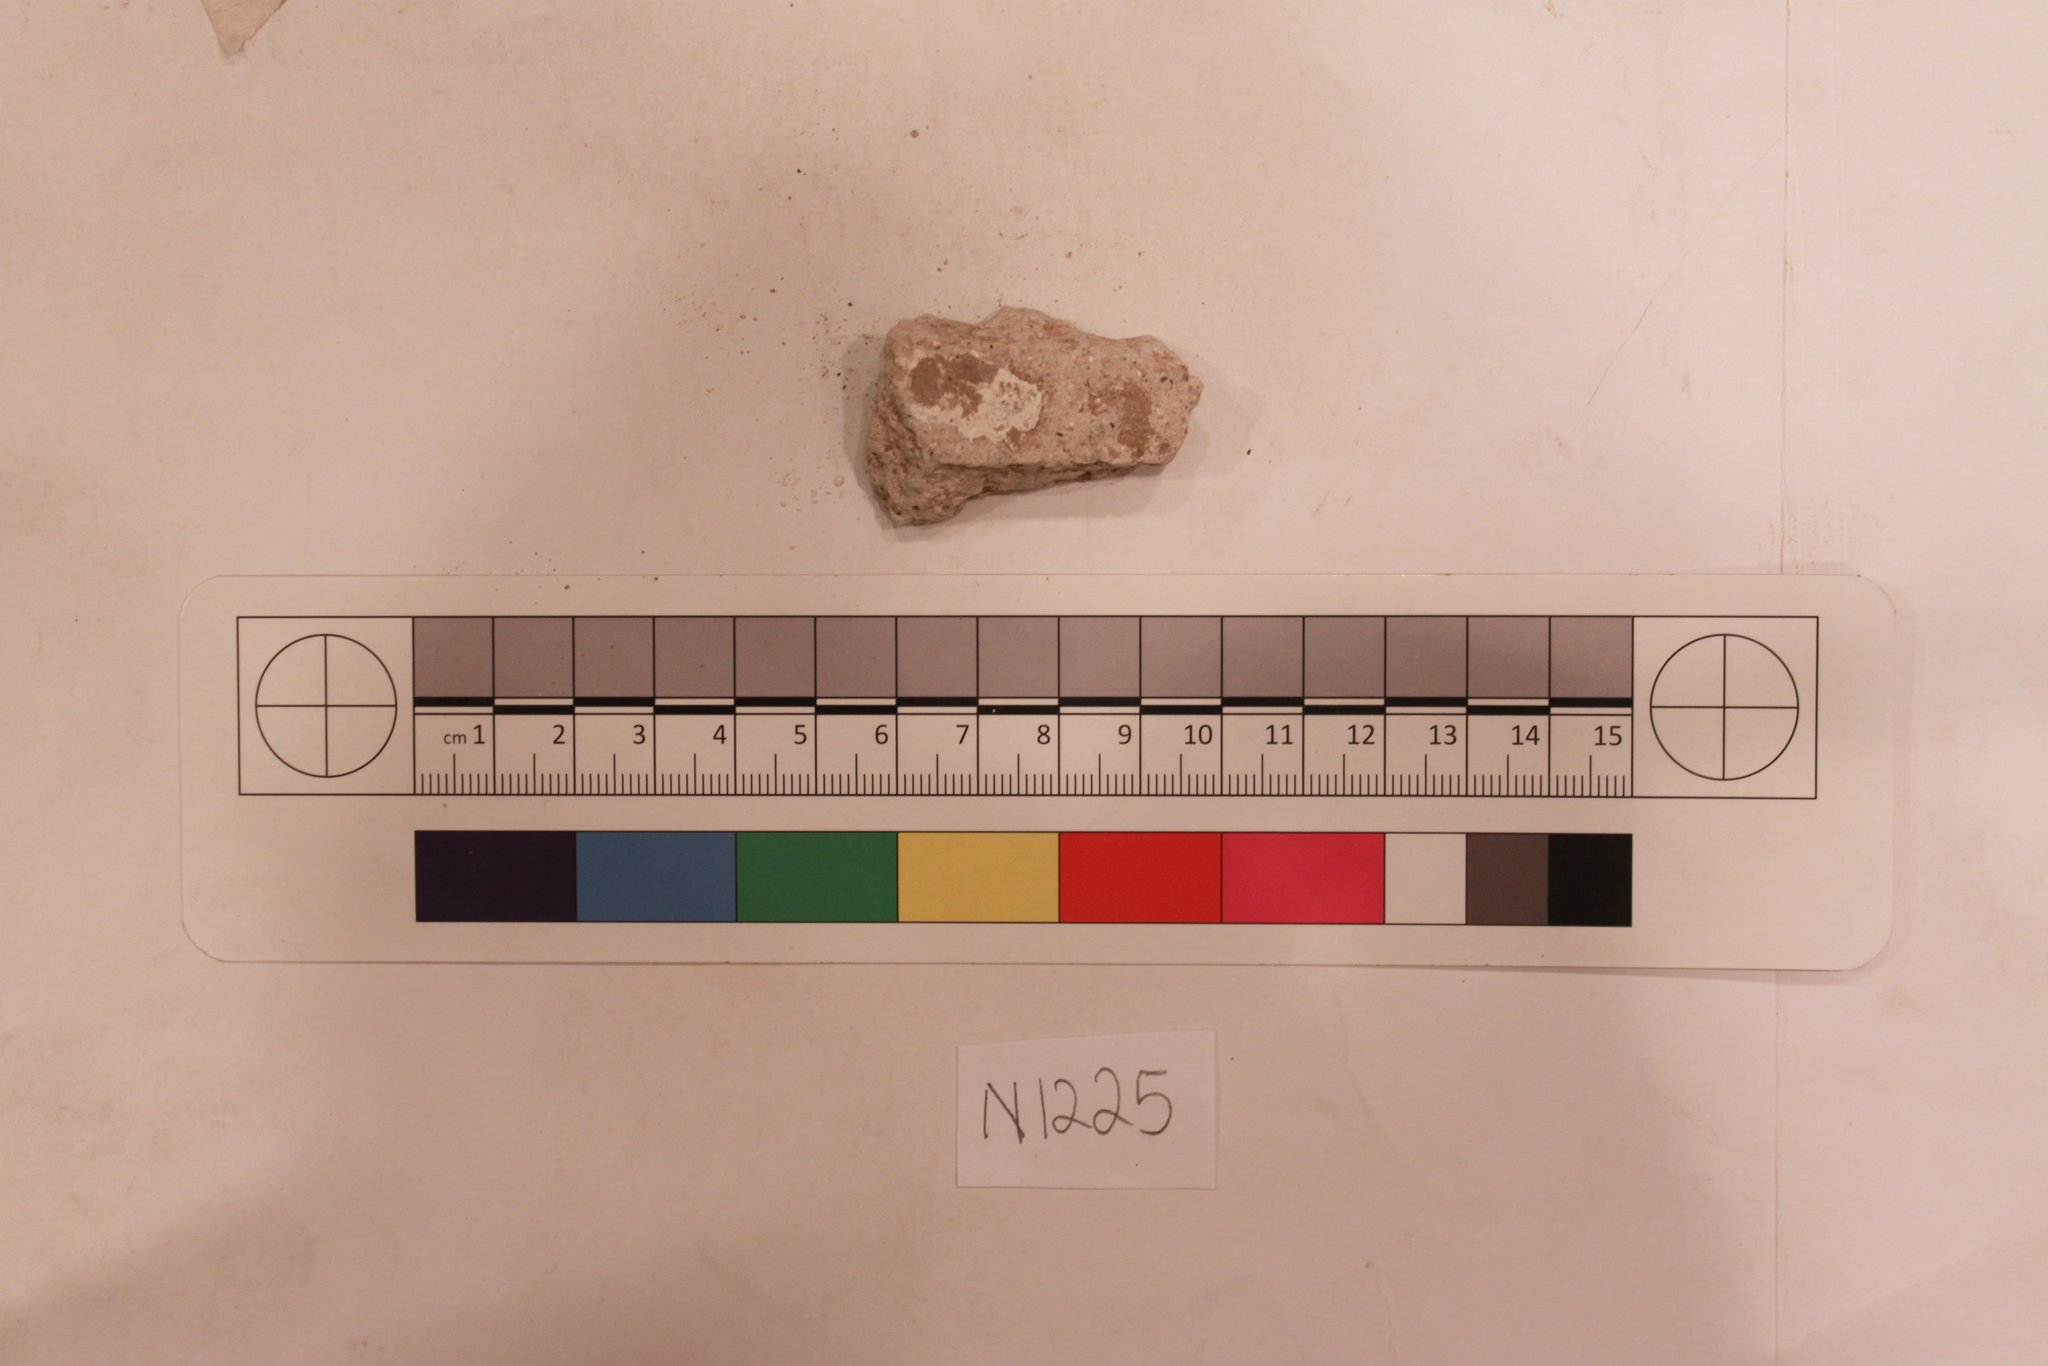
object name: fragment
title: Stucco Fragment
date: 701-1200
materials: plaster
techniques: carving, painting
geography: iran